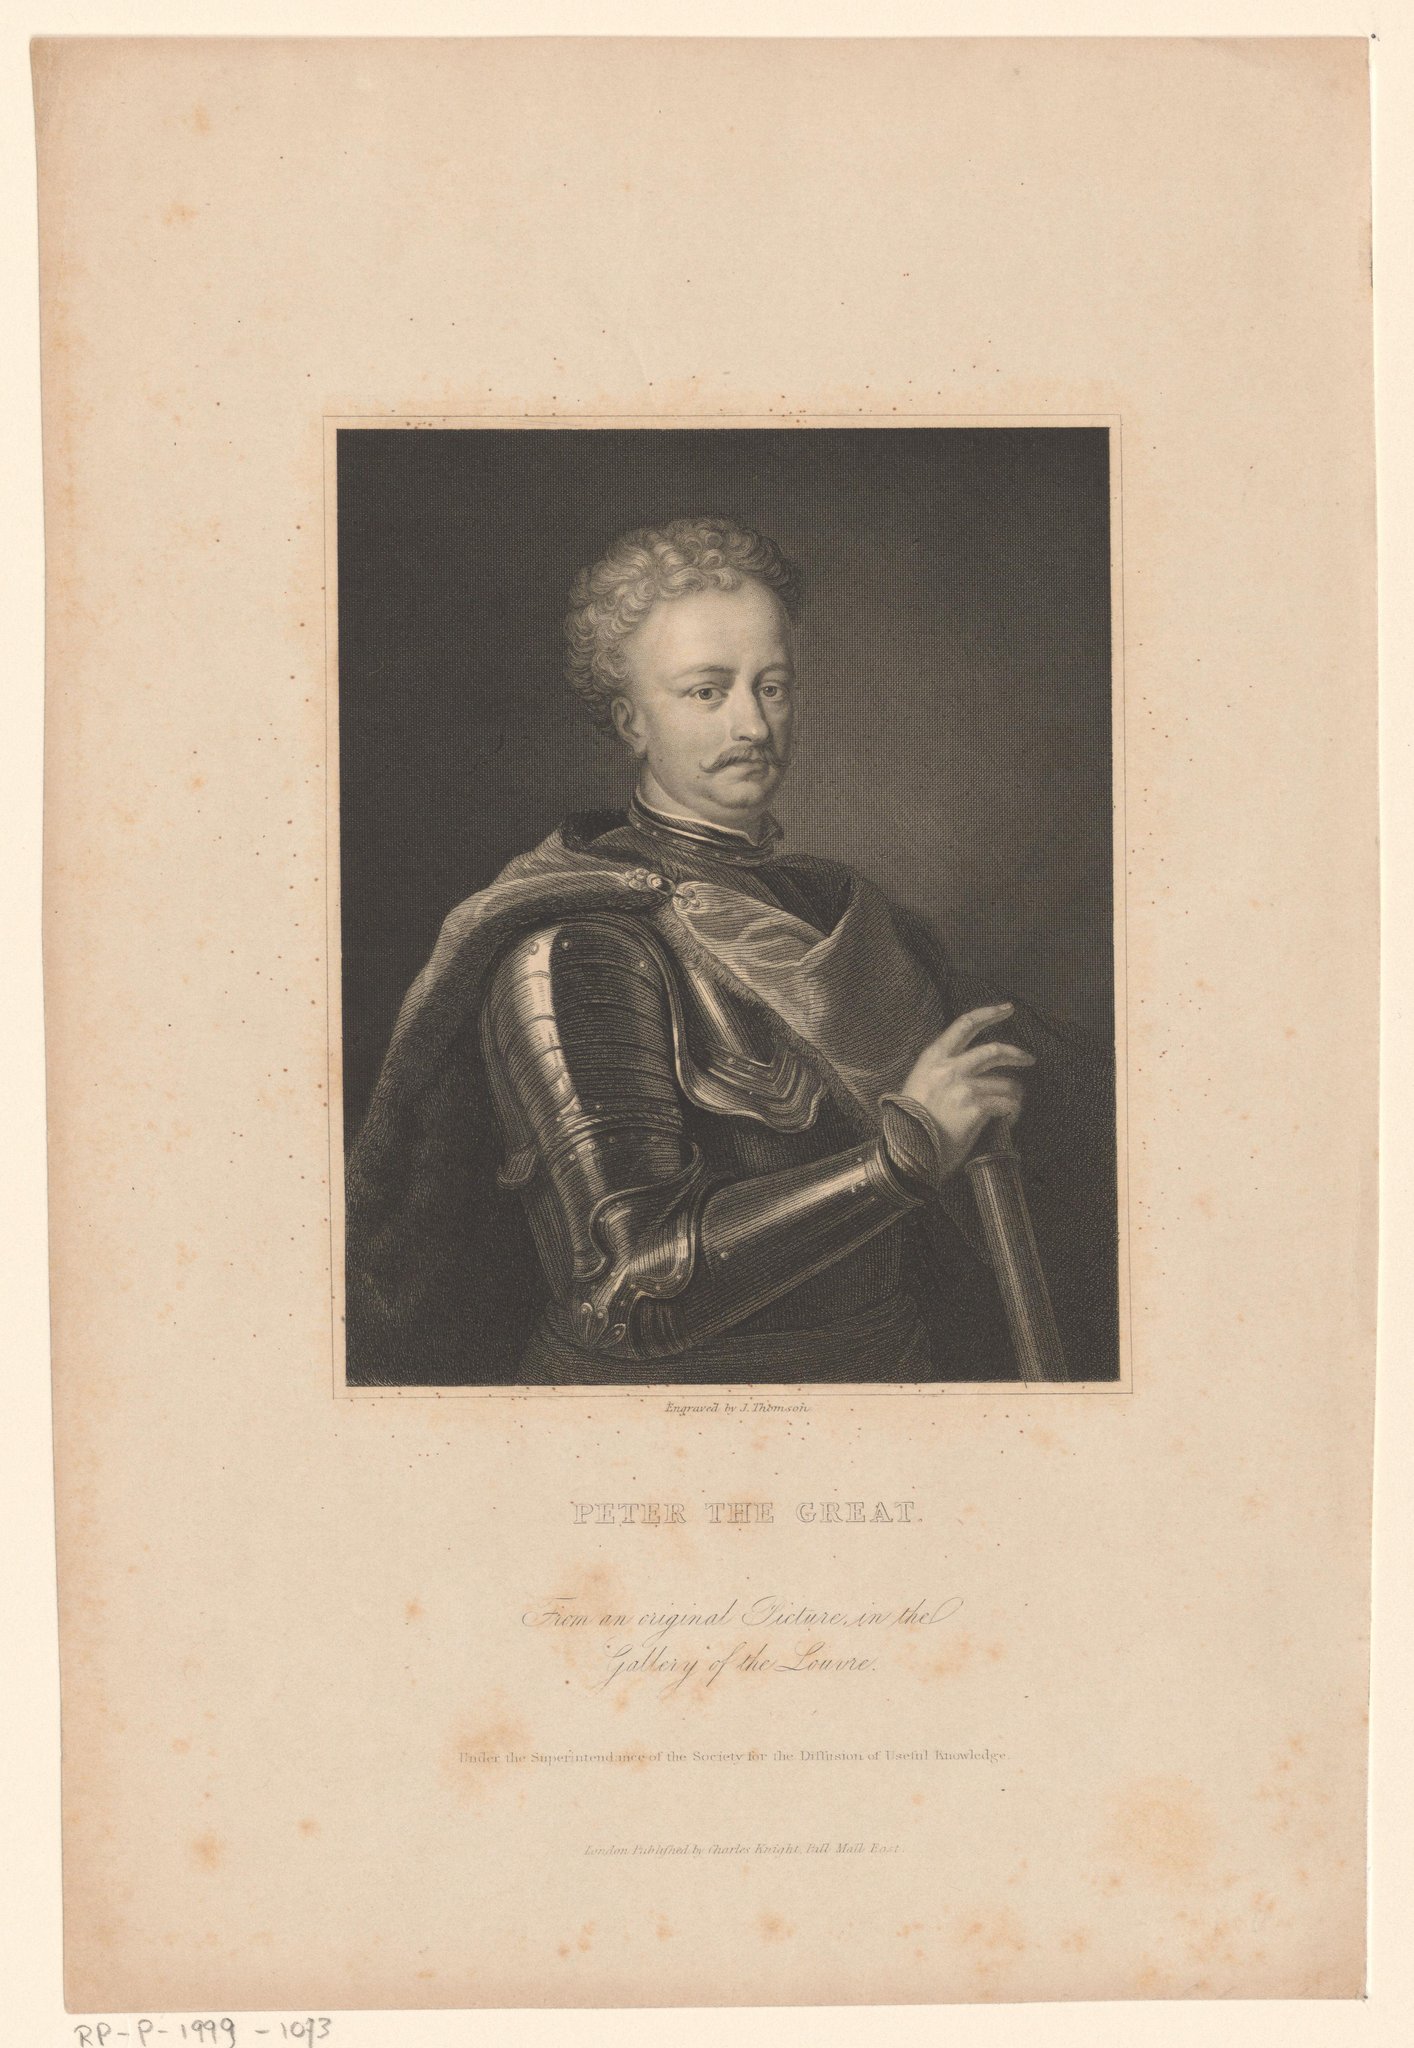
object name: print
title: Portret van Peter I de Grote, tsaar van Rusland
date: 1815-1850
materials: paper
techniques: engraving, etching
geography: london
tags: peter i de grote (tsaar van rusland), armour, adult man, historical persons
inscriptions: collector's mark: Lugt 2760, collector's mark: Lugt 2228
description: Prent mogelijk uit een uitgave van: The Penny Magazine.